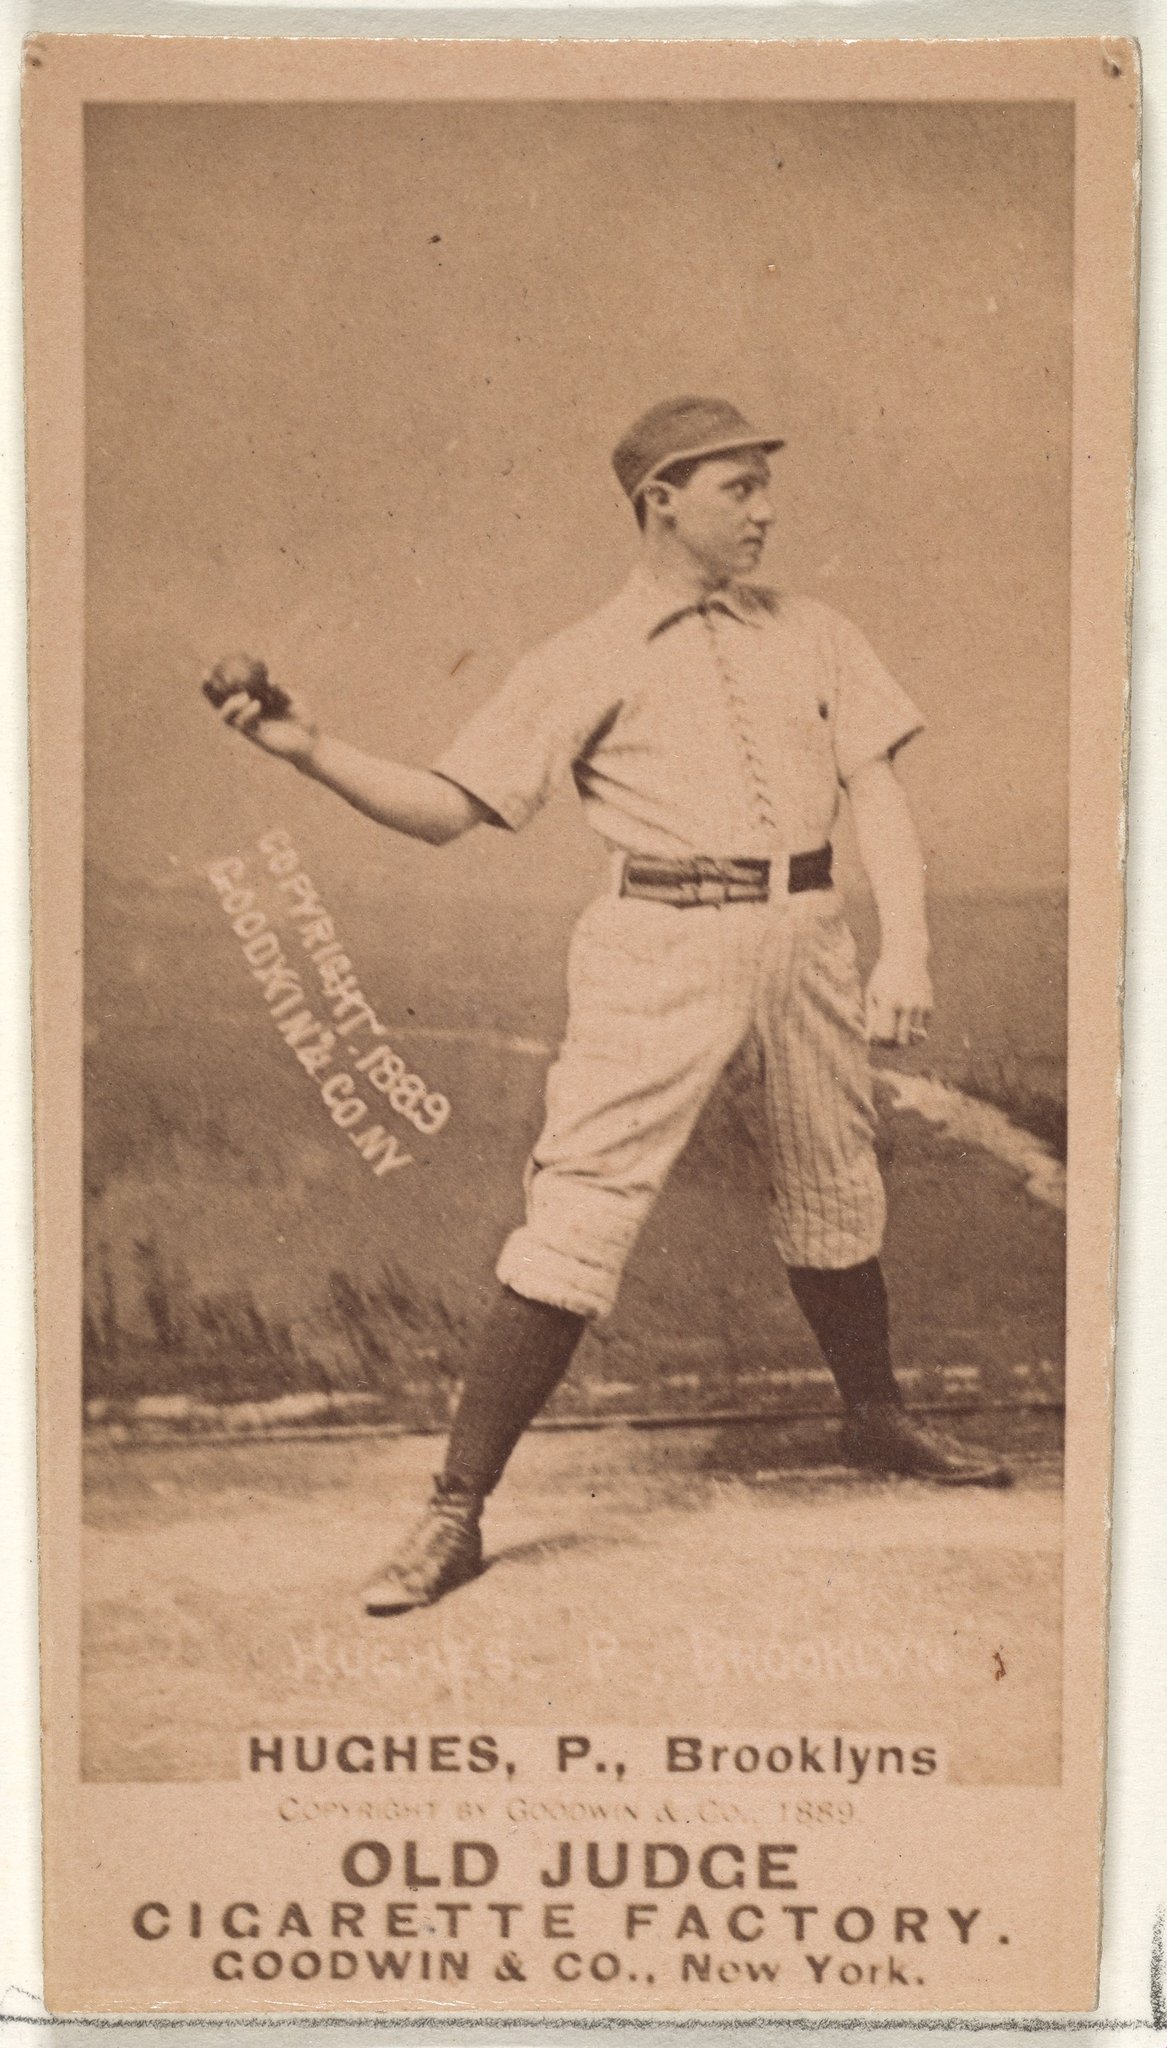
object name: baseball card, photograph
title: Hughes, Pitcher, Brooklyn Bridegrooms, from the Old Judge series (N172) for Old Judge Cigarettes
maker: goodwin & company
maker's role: publisher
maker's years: 1850-1950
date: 1889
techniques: albumen silver print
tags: men,portraits,baseball,athletes